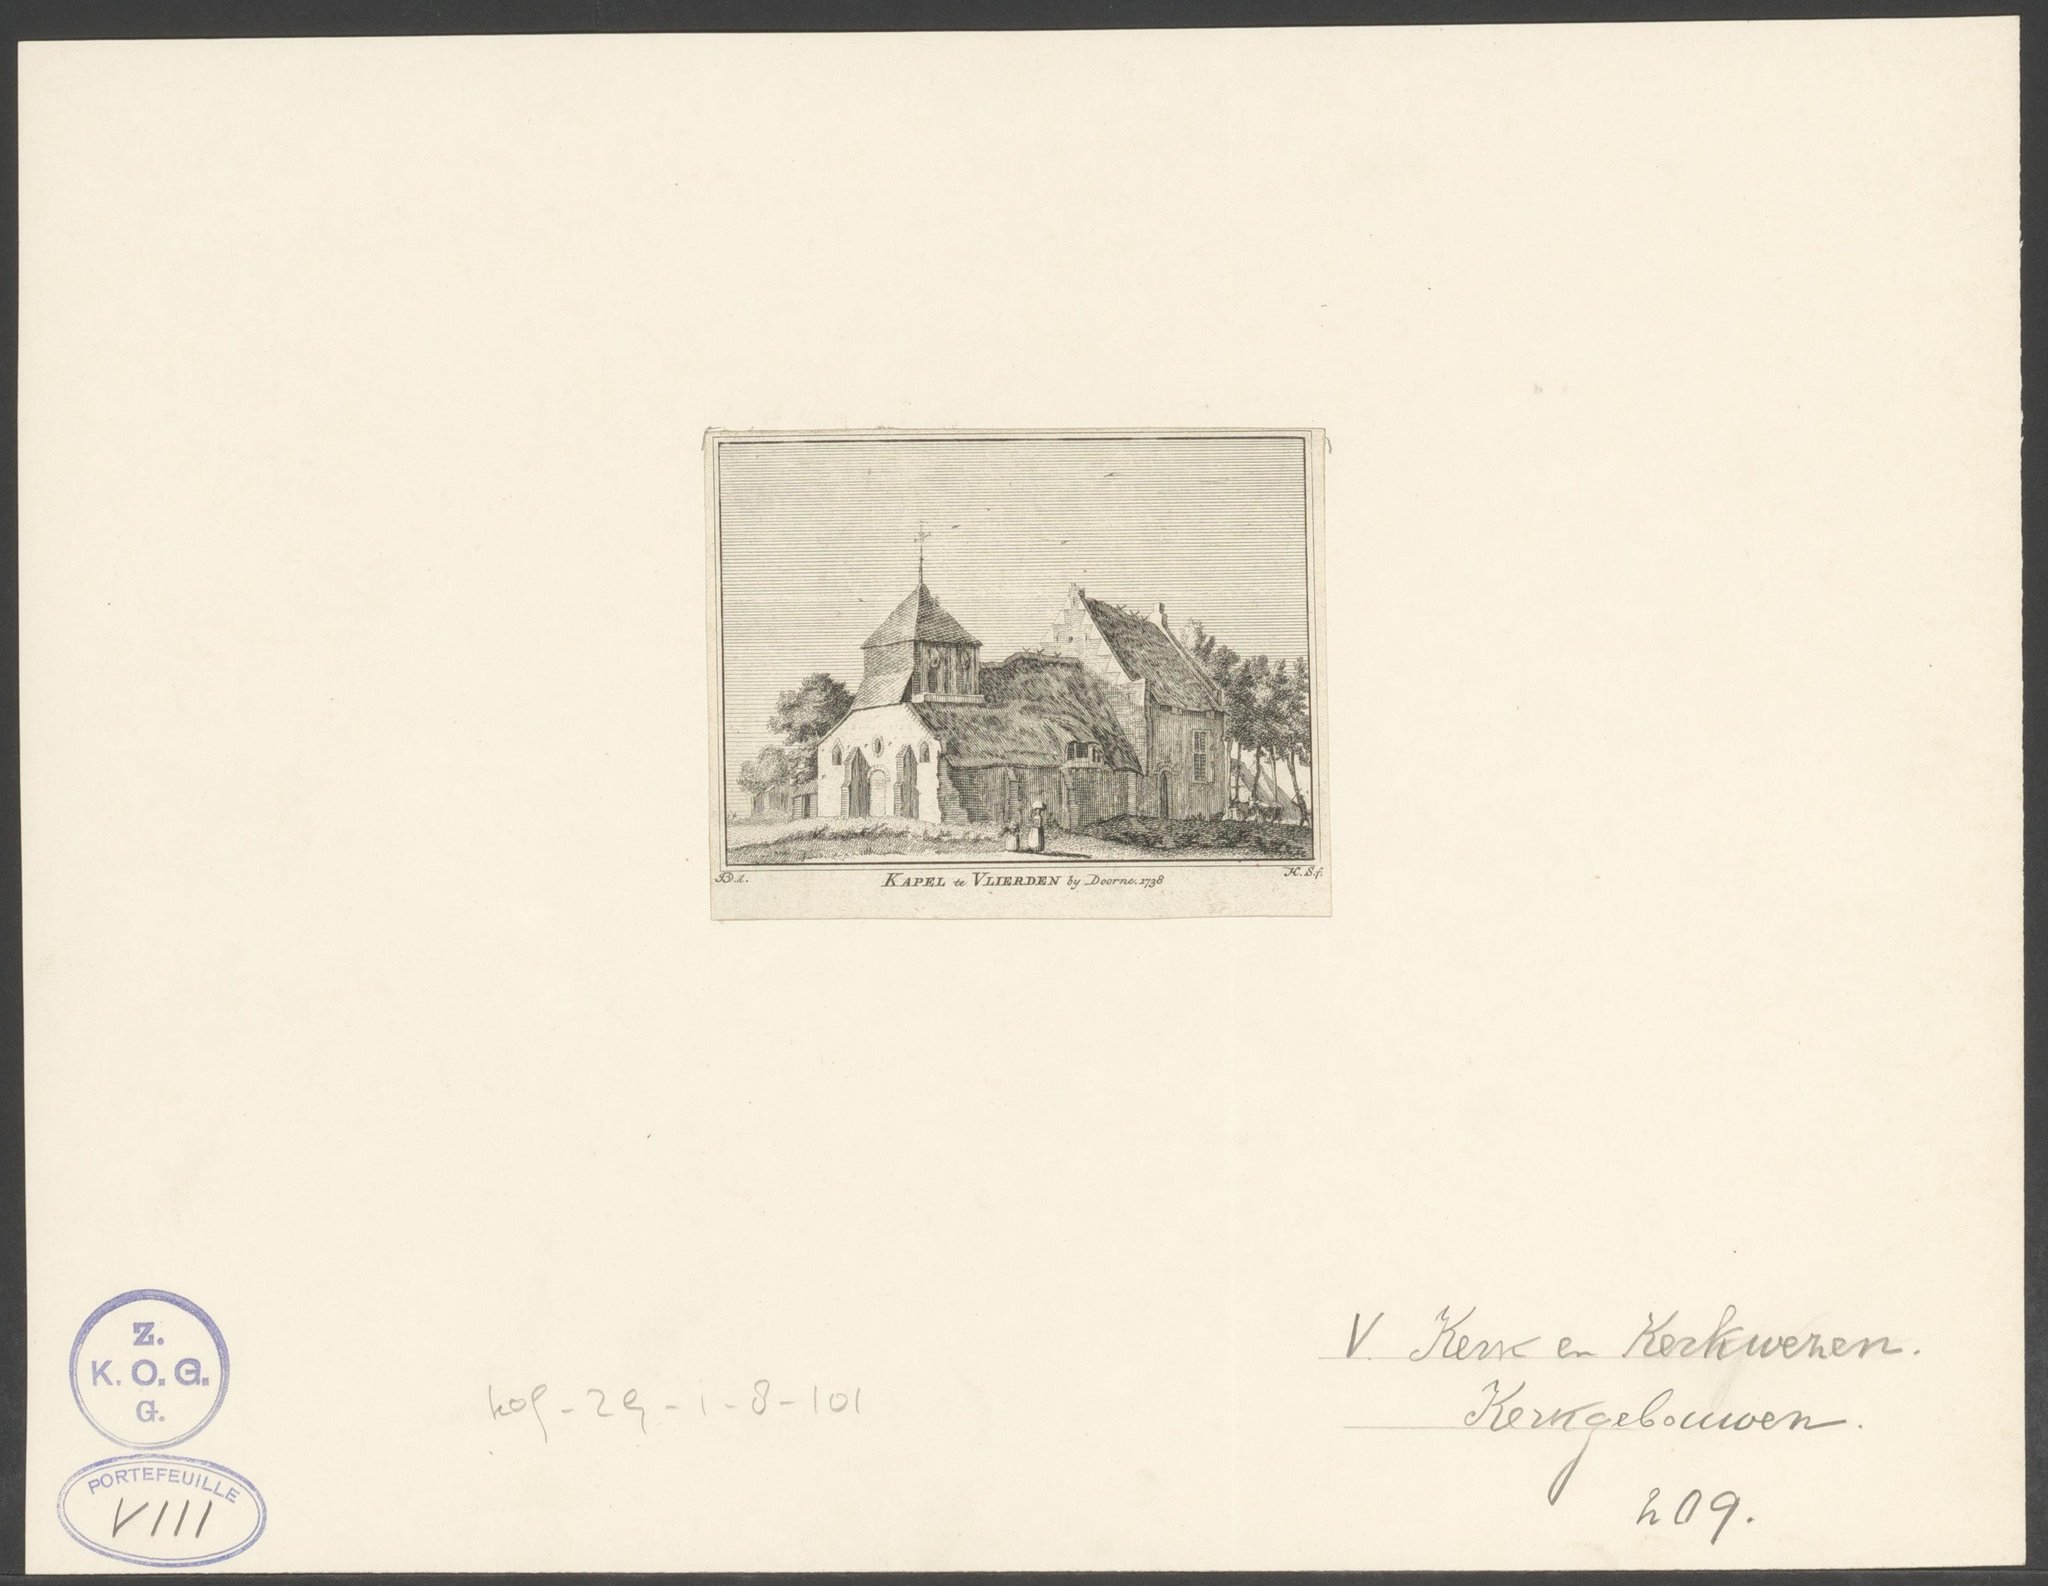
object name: print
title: Gezicht op de kapel van Vlierden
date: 1746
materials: paper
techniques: engraving, etching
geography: amsterdam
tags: church (exterior), church (exterior) - qq - small church, chapel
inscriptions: collector's mark: Lugt 1641, collector's mark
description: Gezicht op de kapel van Vlierden, omstreeks het jaar 1738. Onderste helft van een blad met oorspronkelijk twee voorstellingen. Onderwerpsrubrieken binnen de Atlas Zeden en Gewoonten: Kerk en kerkwezen & Armwezen en liefdadige instellingen; Kerkgebouwen elders. V-Z.